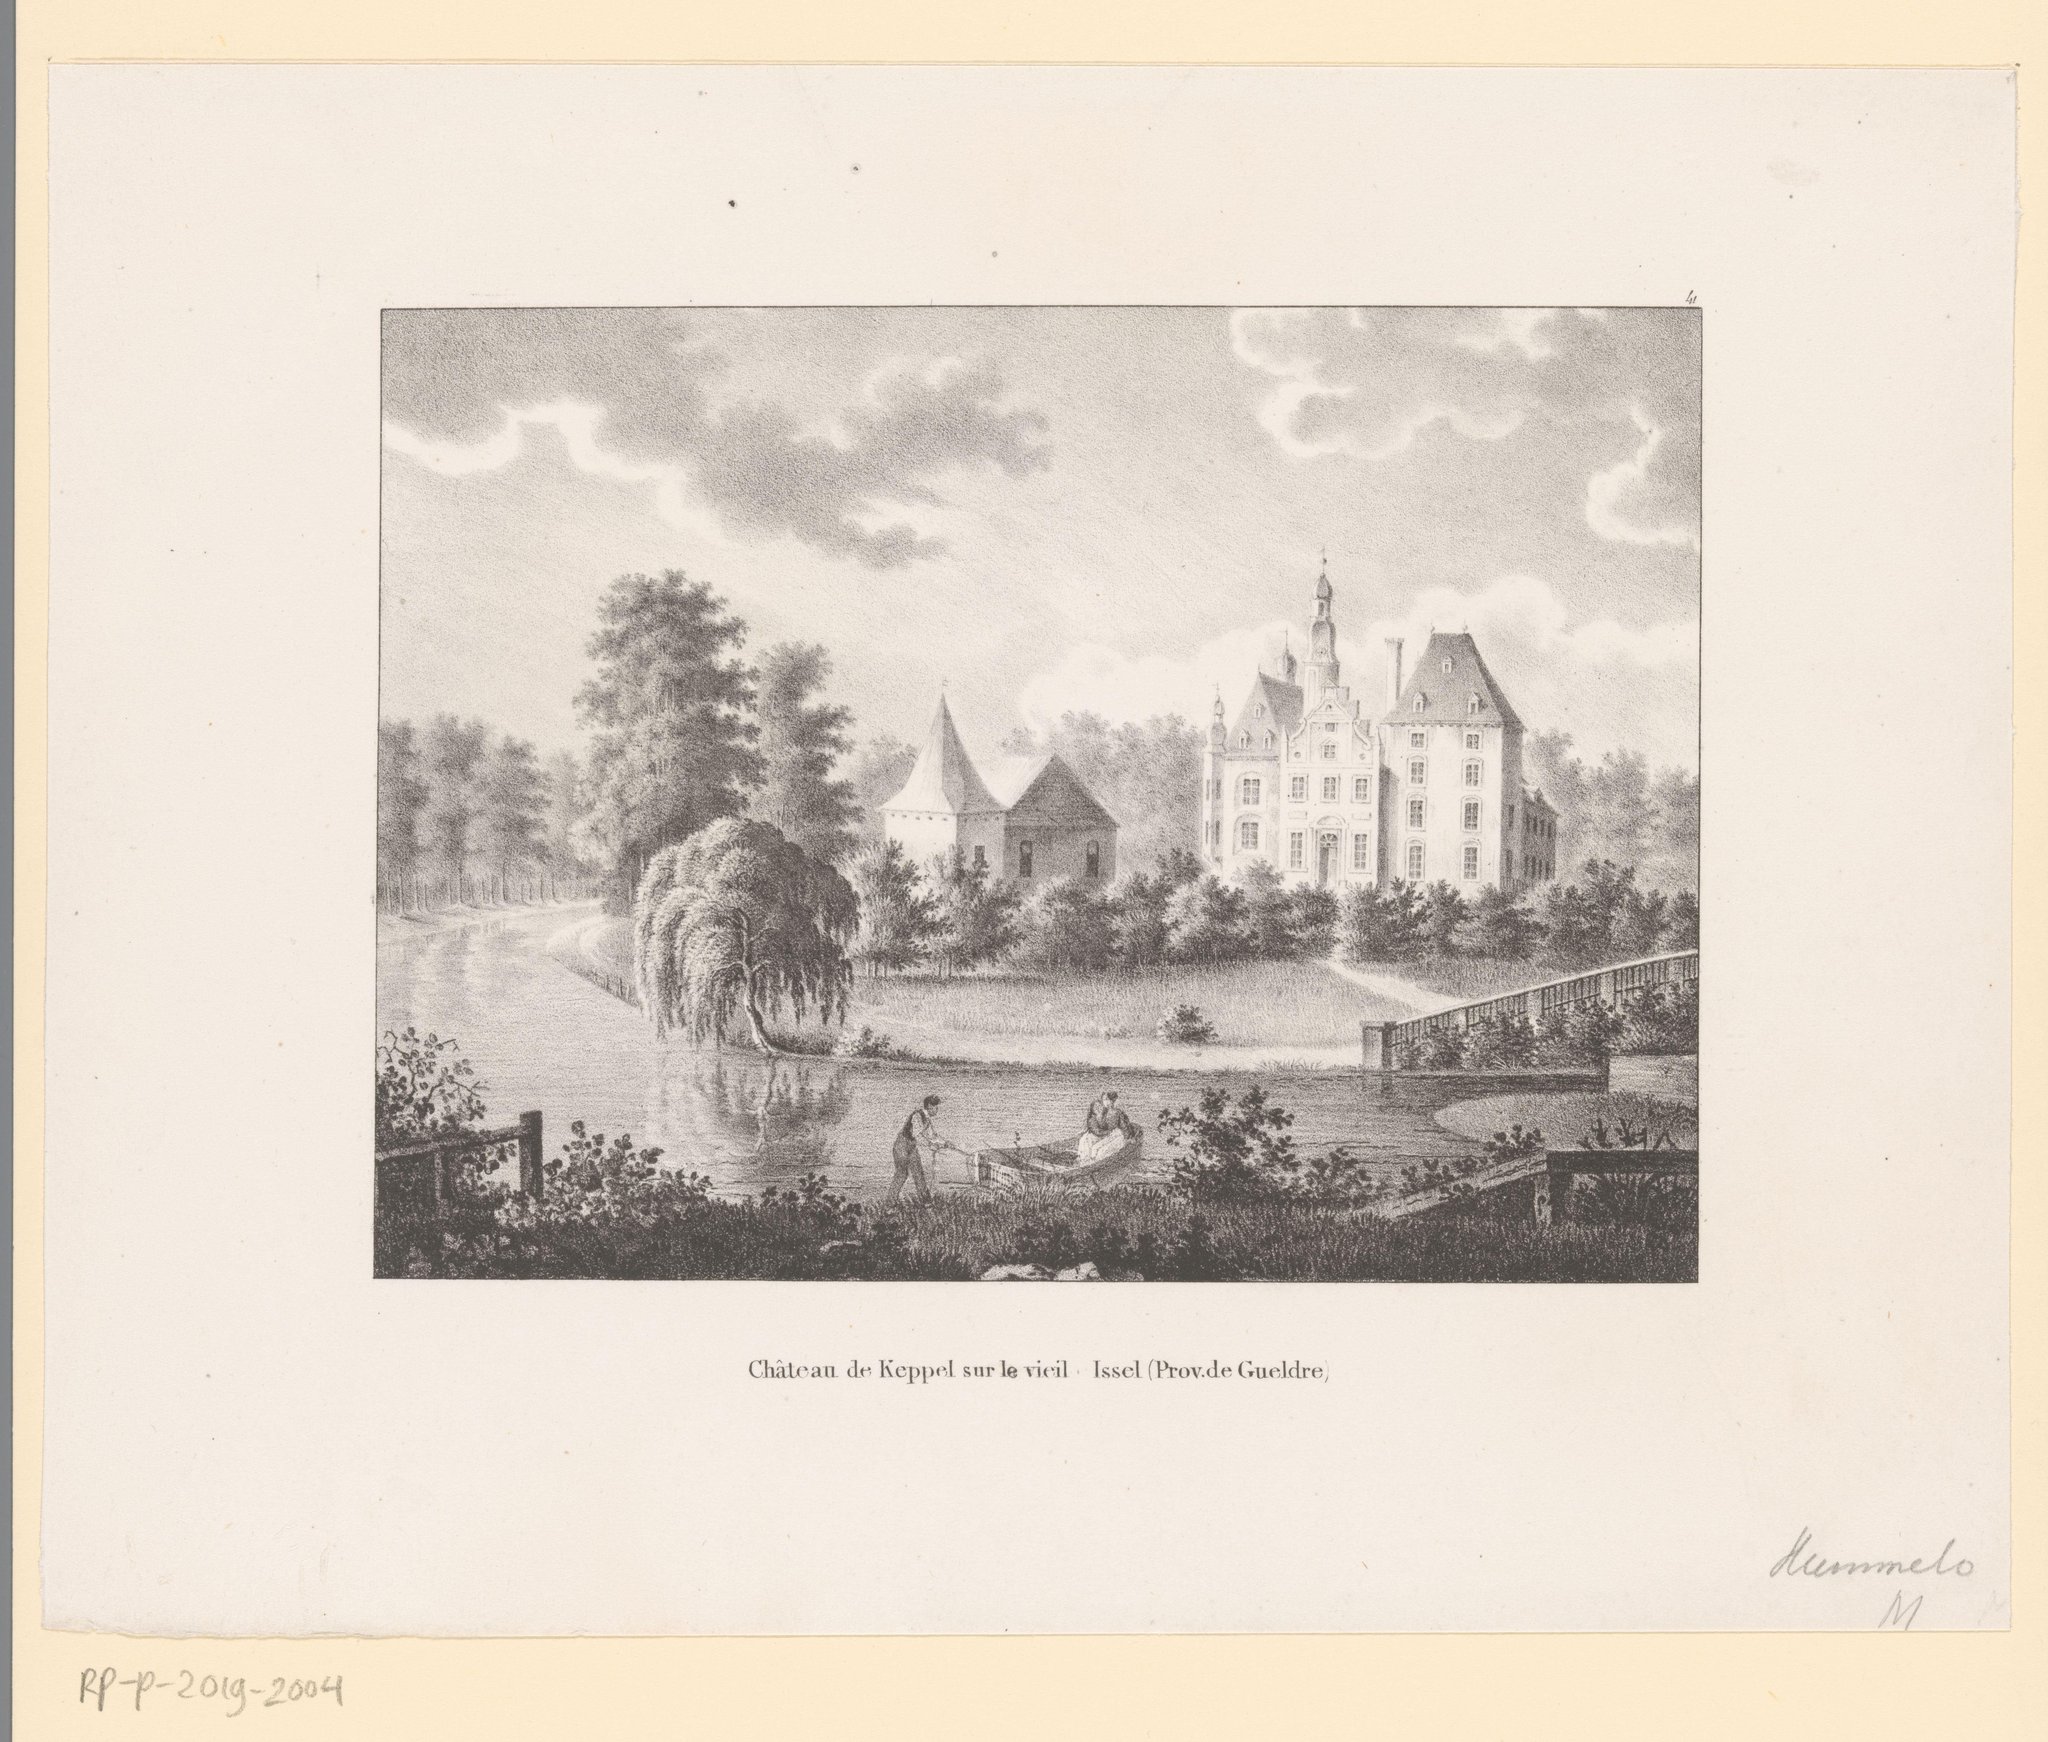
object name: print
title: Gezicht op Kasteel Keppel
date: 1827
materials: paper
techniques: lithograph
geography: brussels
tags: castle, landscape with tower or castle, brook (+ landscape with figures, staffage)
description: Prent uit: Cloet, J.J. de. Chateaux et Monumens des Pays-Bas Faisant suite au Voyage pittoresque. Brussel: J.B.A.M. Jobard, 1827.